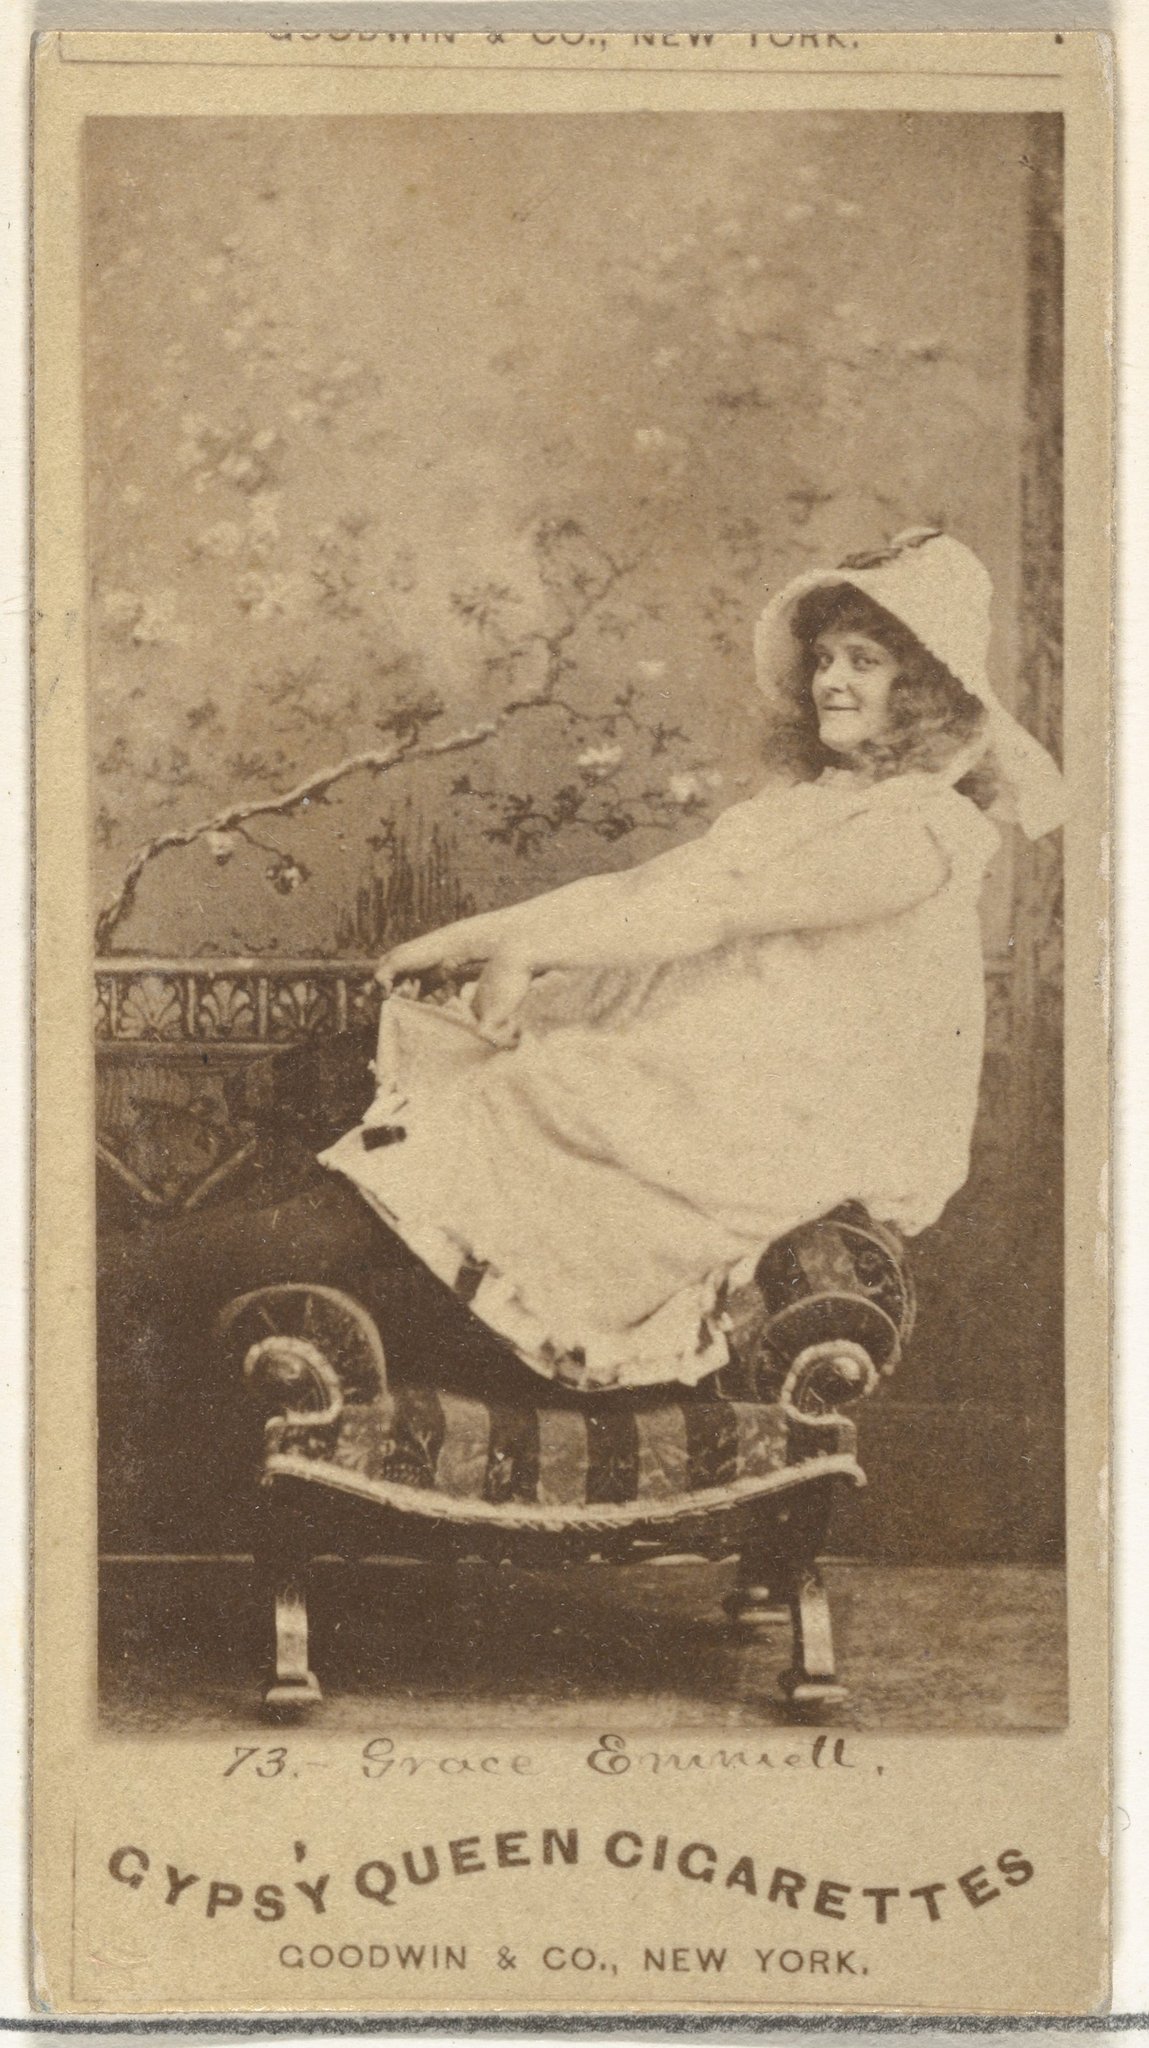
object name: photograph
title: Grace Emmiett, from the Actors and Actresses series (N171) for Gypsy Queen Cigarettes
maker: goodwin & company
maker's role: publisher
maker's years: 1850-1950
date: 1886-1890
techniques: albumen silver print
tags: portraits,women,actresses